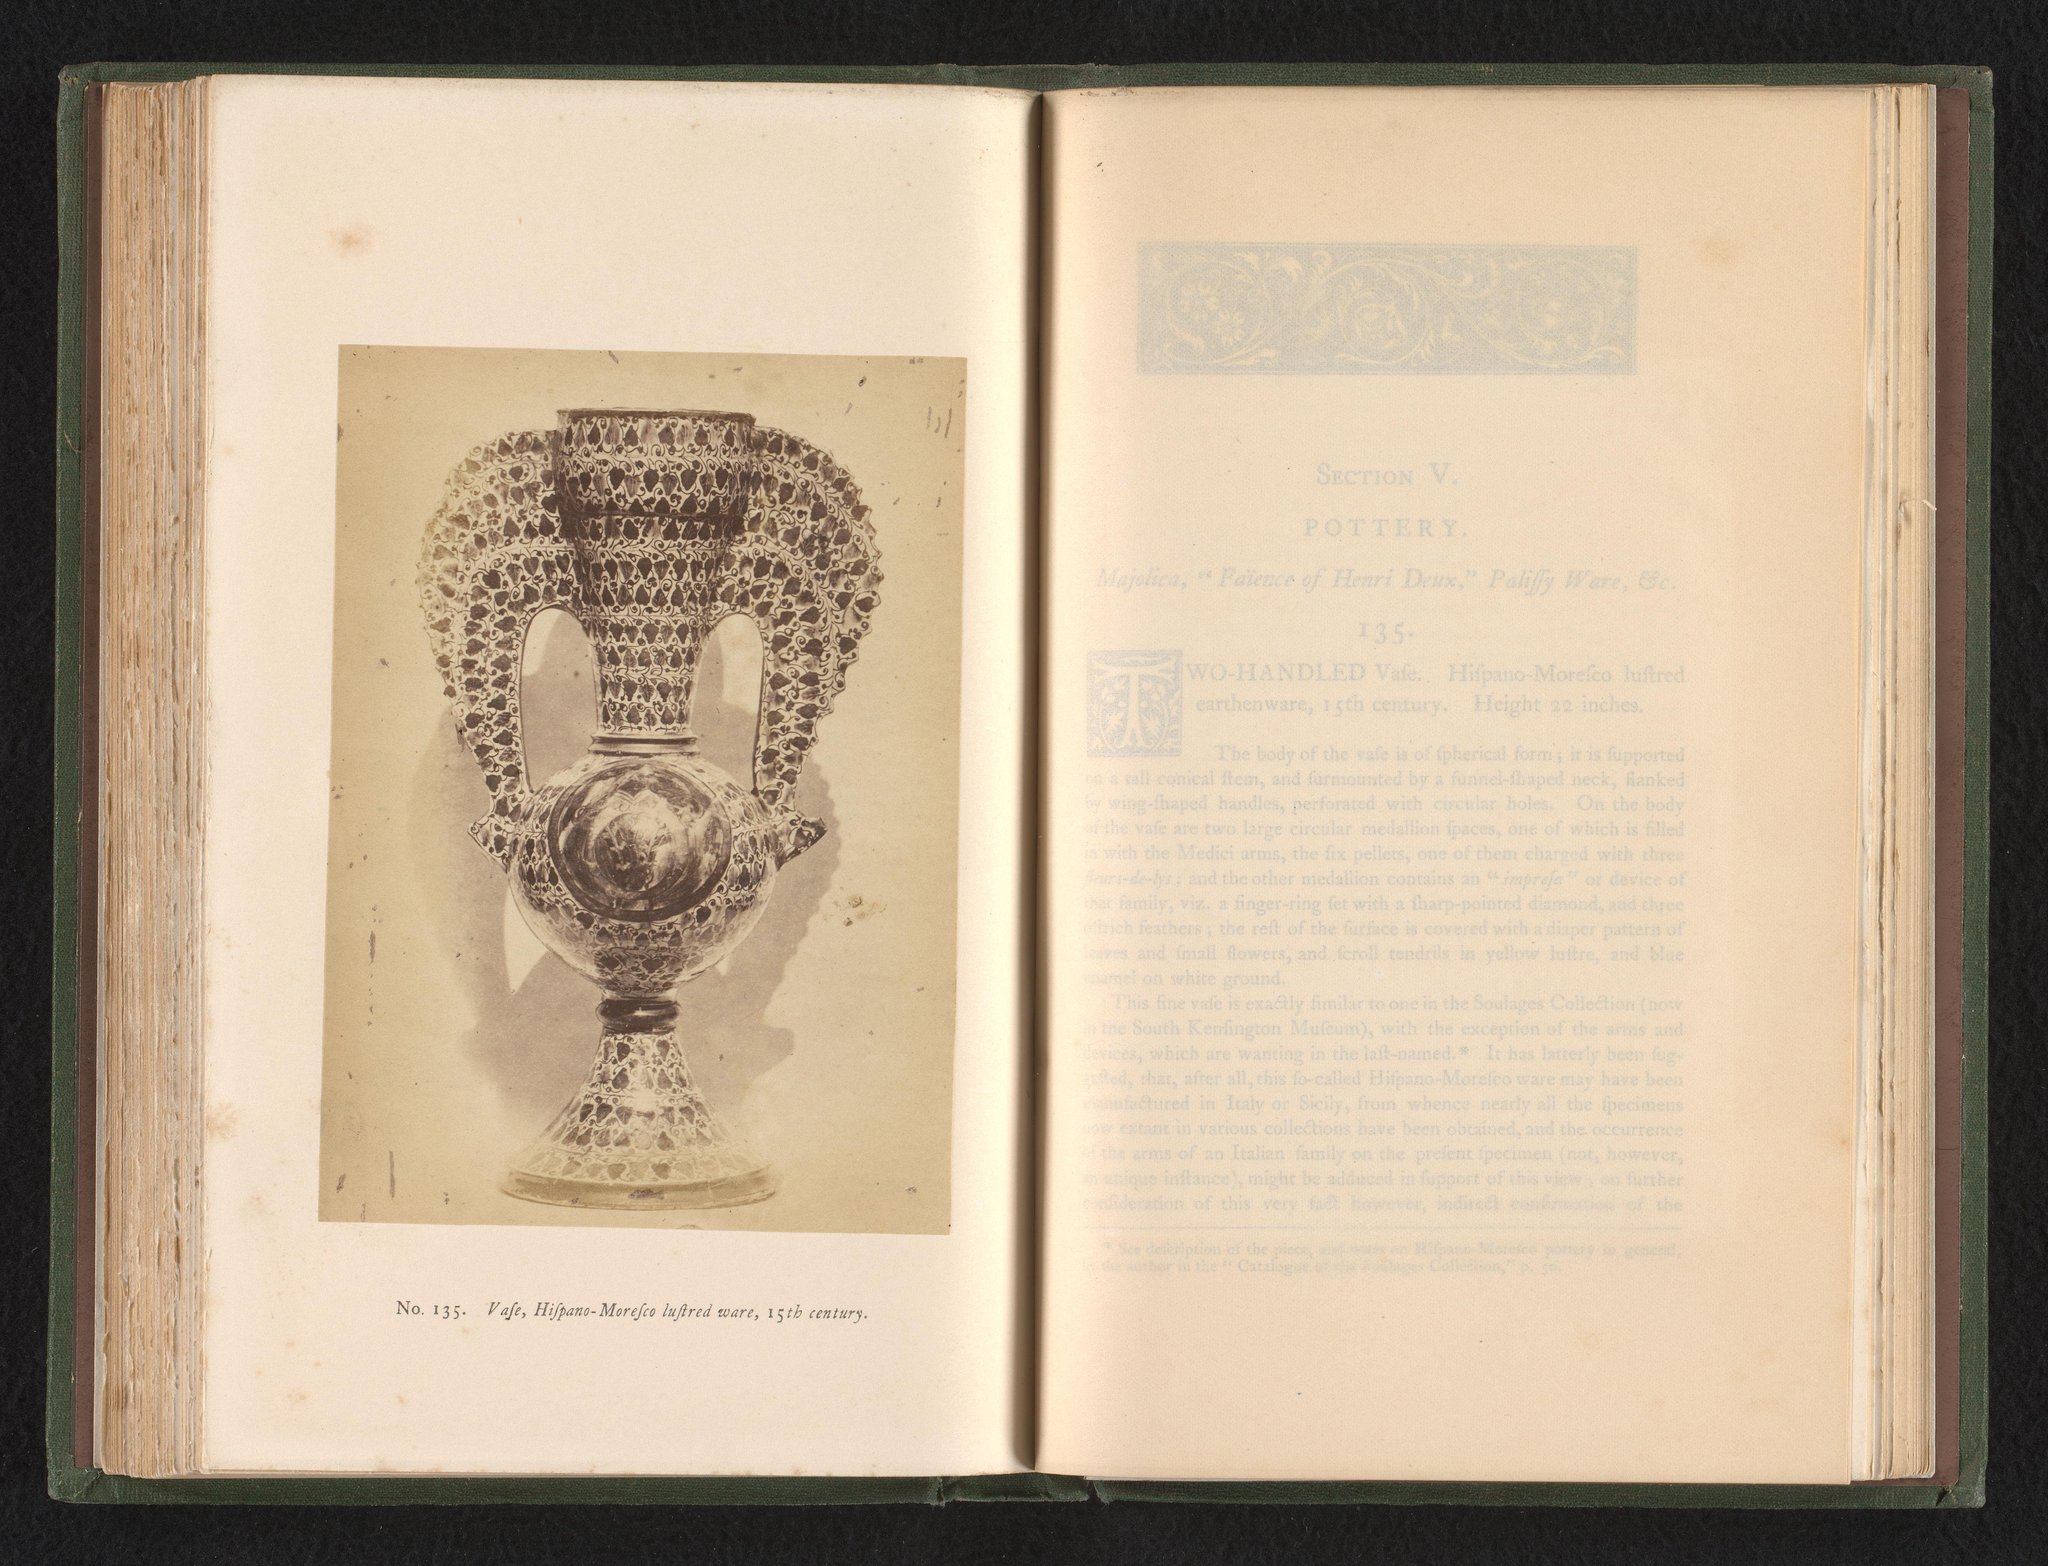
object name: page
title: Vase, Hispano-Moresco lustred ware, 15th. century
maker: Anonymous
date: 1851-1861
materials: paper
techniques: albumen print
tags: container of stone: stone vase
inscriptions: number: ‘No. 135.’